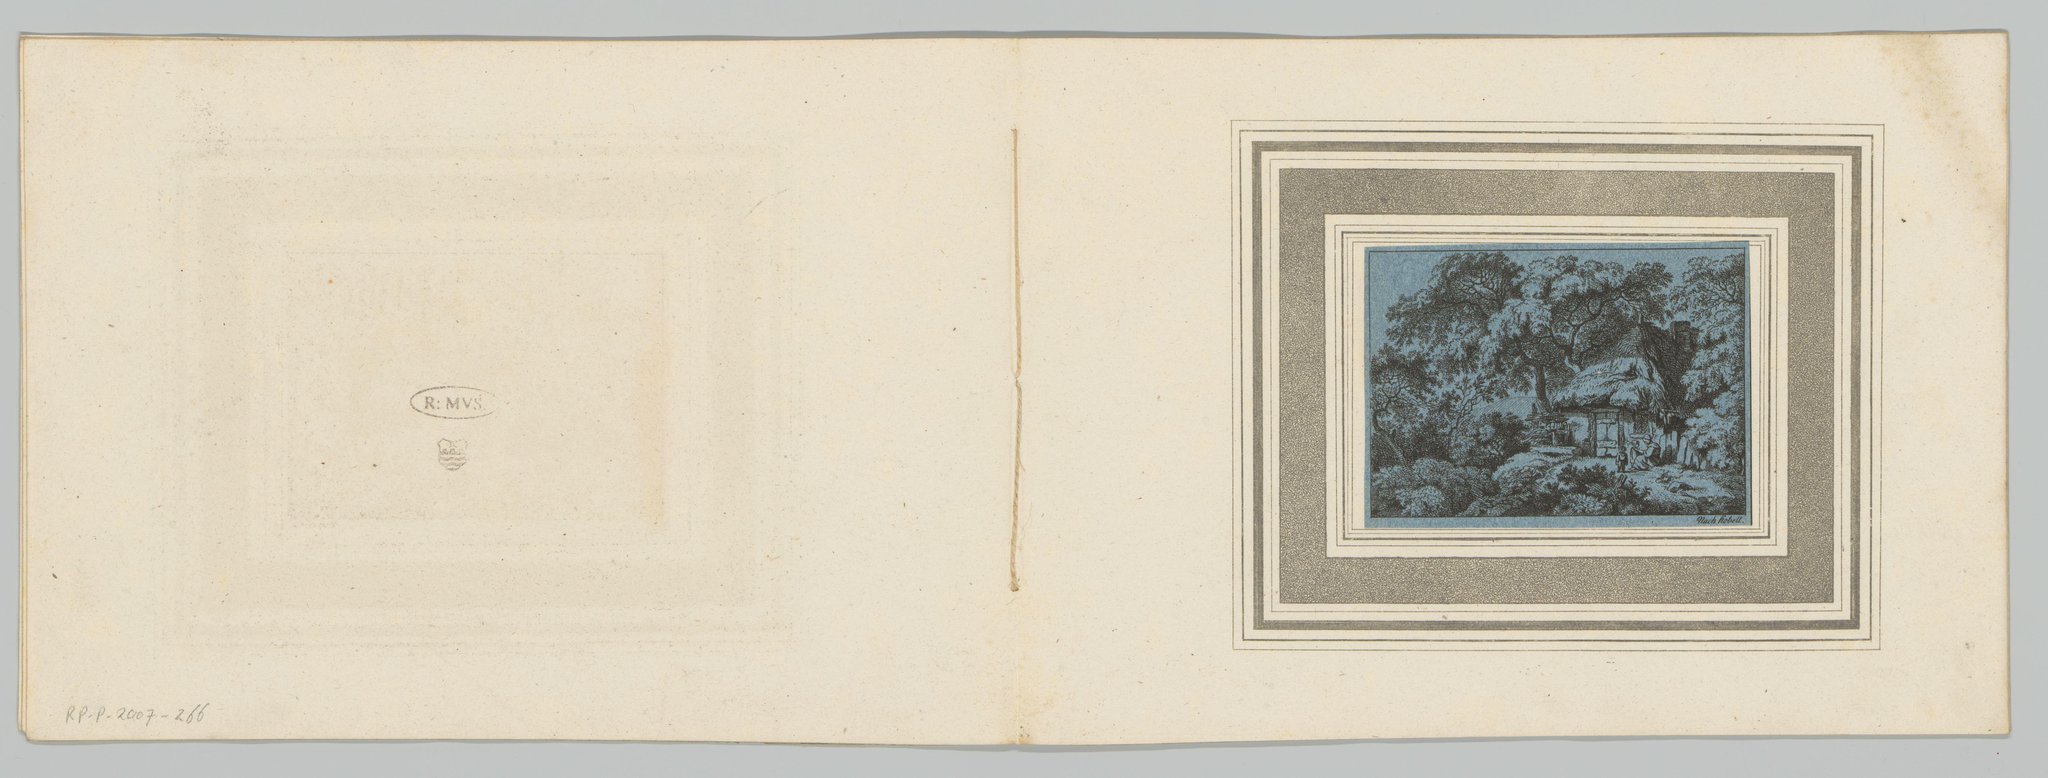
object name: print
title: Moeder met kinderen voor een hut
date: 1772-1828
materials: paper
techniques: etching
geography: vienna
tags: forest, wood, hut, cabin, lodge, mother and child(ren), woman and child(ren) (family group)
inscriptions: collector's mark: Lugt 2760, collector's mark: Lugt 2228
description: Vierde prent in album 'VI Landschaften nach Kobell von K. Ponheimer IV. Heft' met zes prenten.